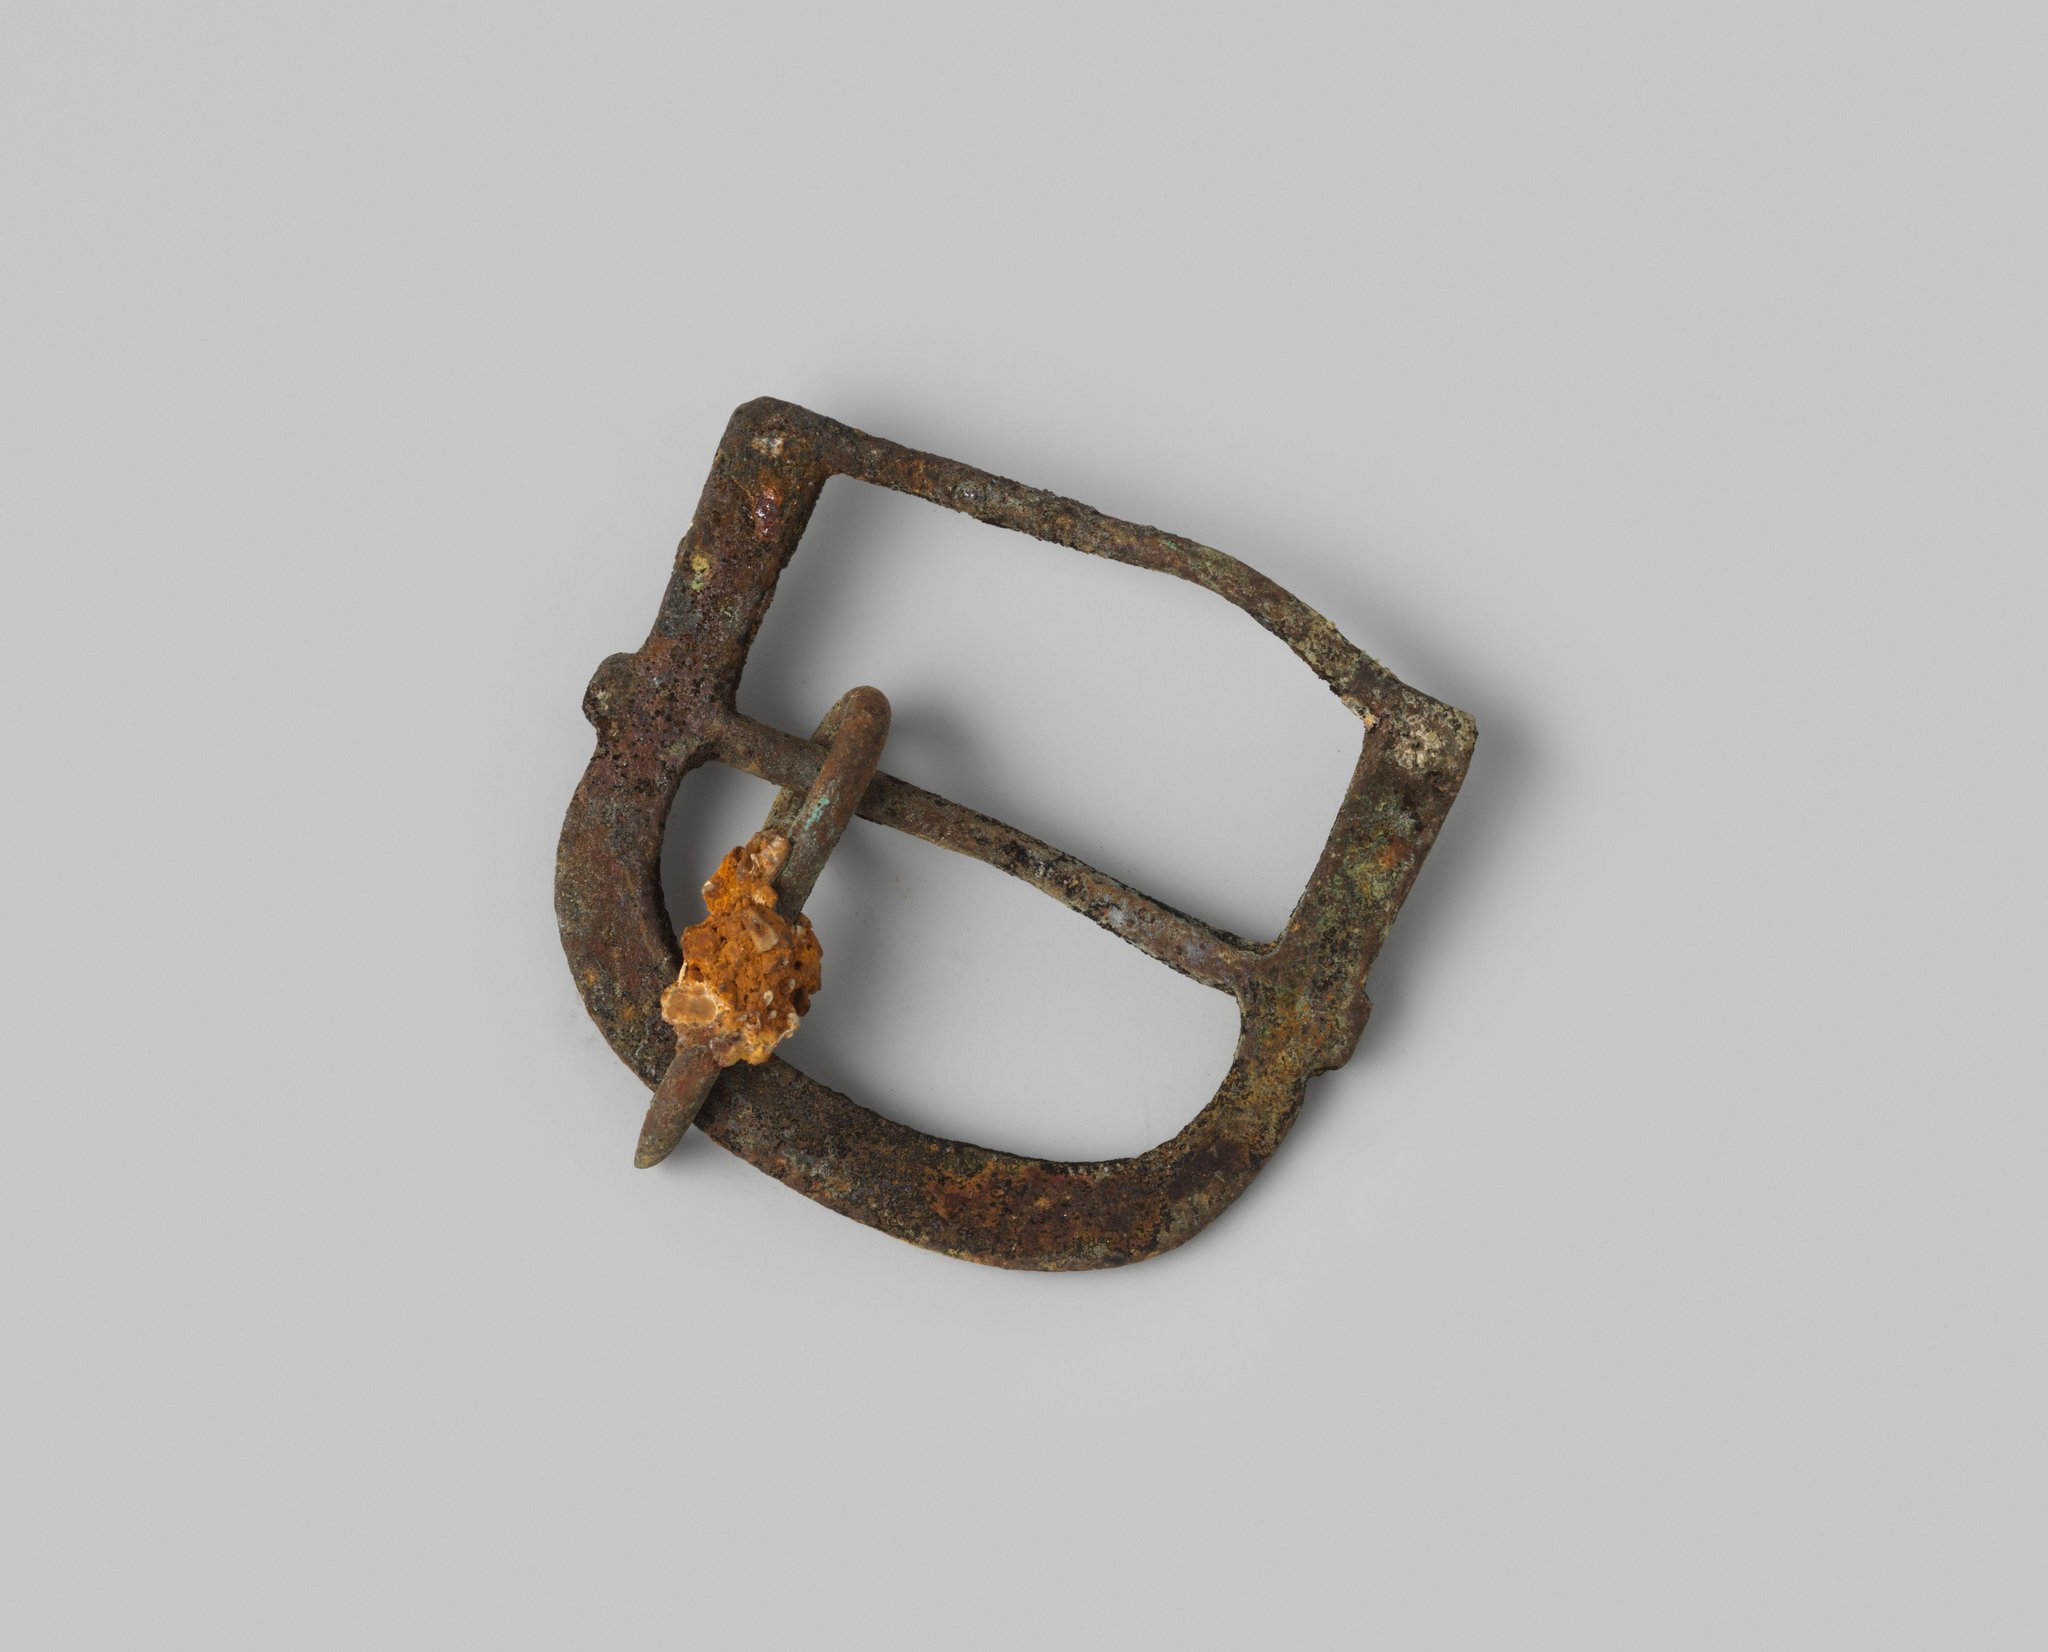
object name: belt buckle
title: Riemgesp uit het wrak van de Oost-Indiëvaarder Hollandia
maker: Anonymous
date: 1700-1743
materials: copper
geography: netherlands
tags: verenigde oostindische compagnie, hollandia (schip), annet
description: D-shaped, ring and tongue, id. NG 1979-177H537, belt buckle.